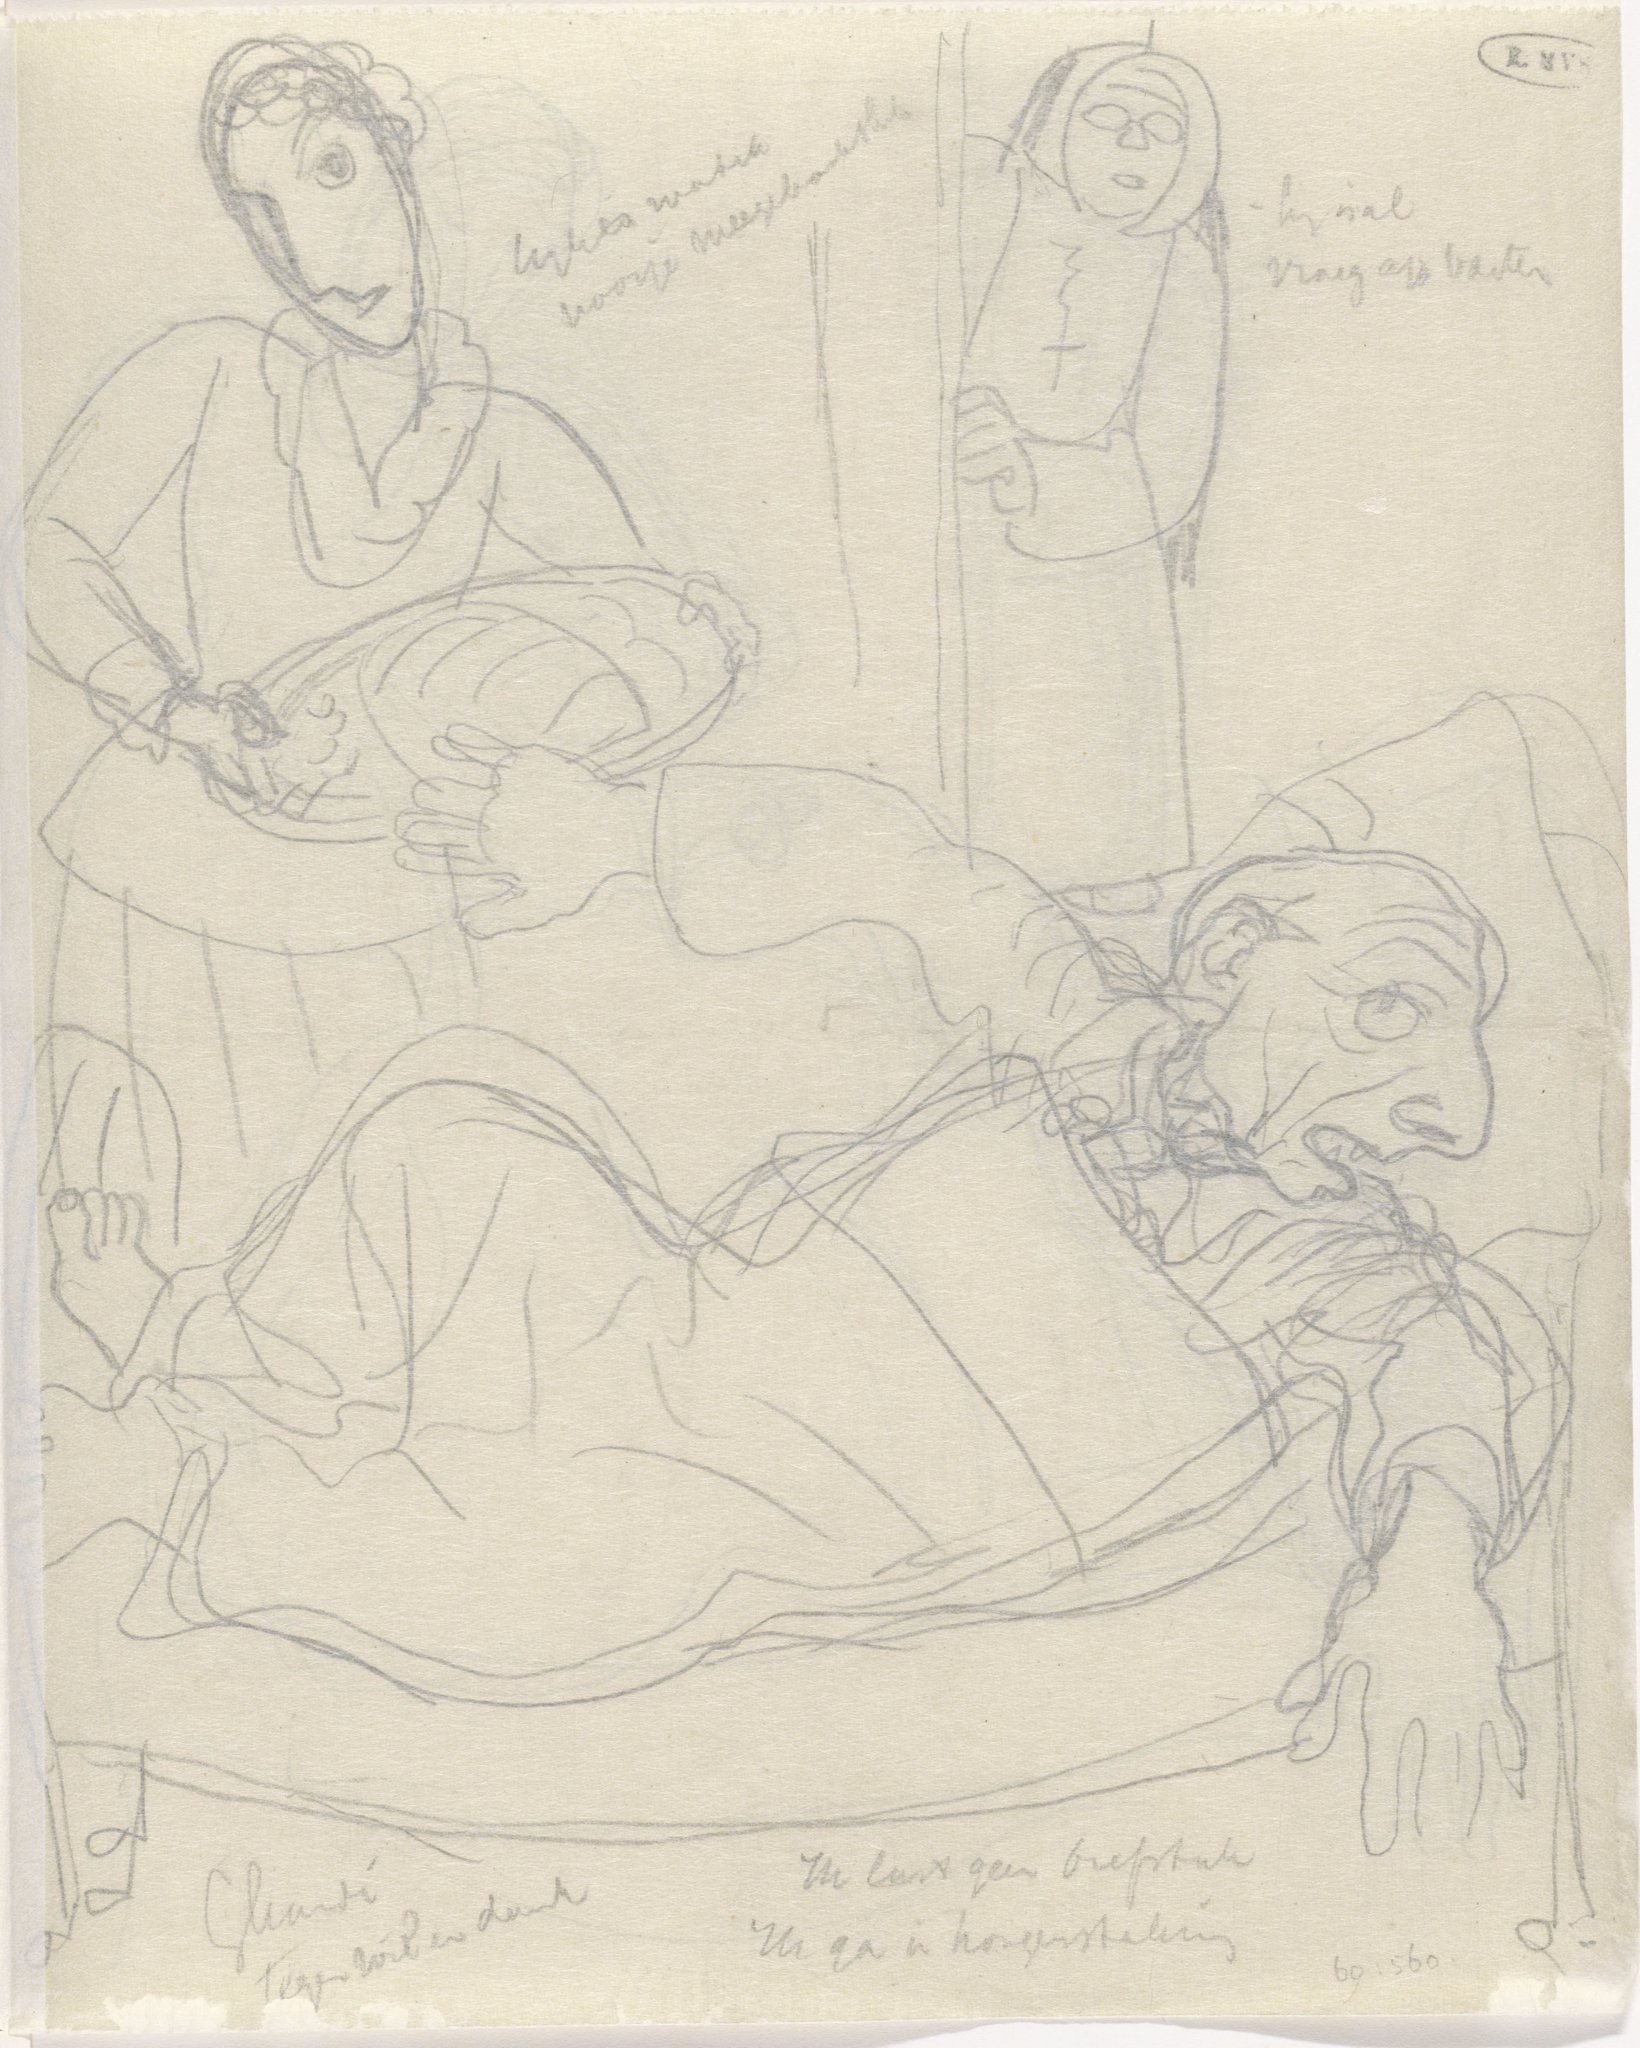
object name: drawing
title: Karikatuur van Leo Gestel op zijn ziekbed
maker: leo gestel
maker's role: draughtsman, print maker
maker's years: 1881-1941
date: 1911-1941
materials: paper, pencil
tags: print maker, draughtsman, leo gestel, sick-bed, historical persons, portrait, self-portrait of artist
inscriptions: collector's mark: Lugt 2228